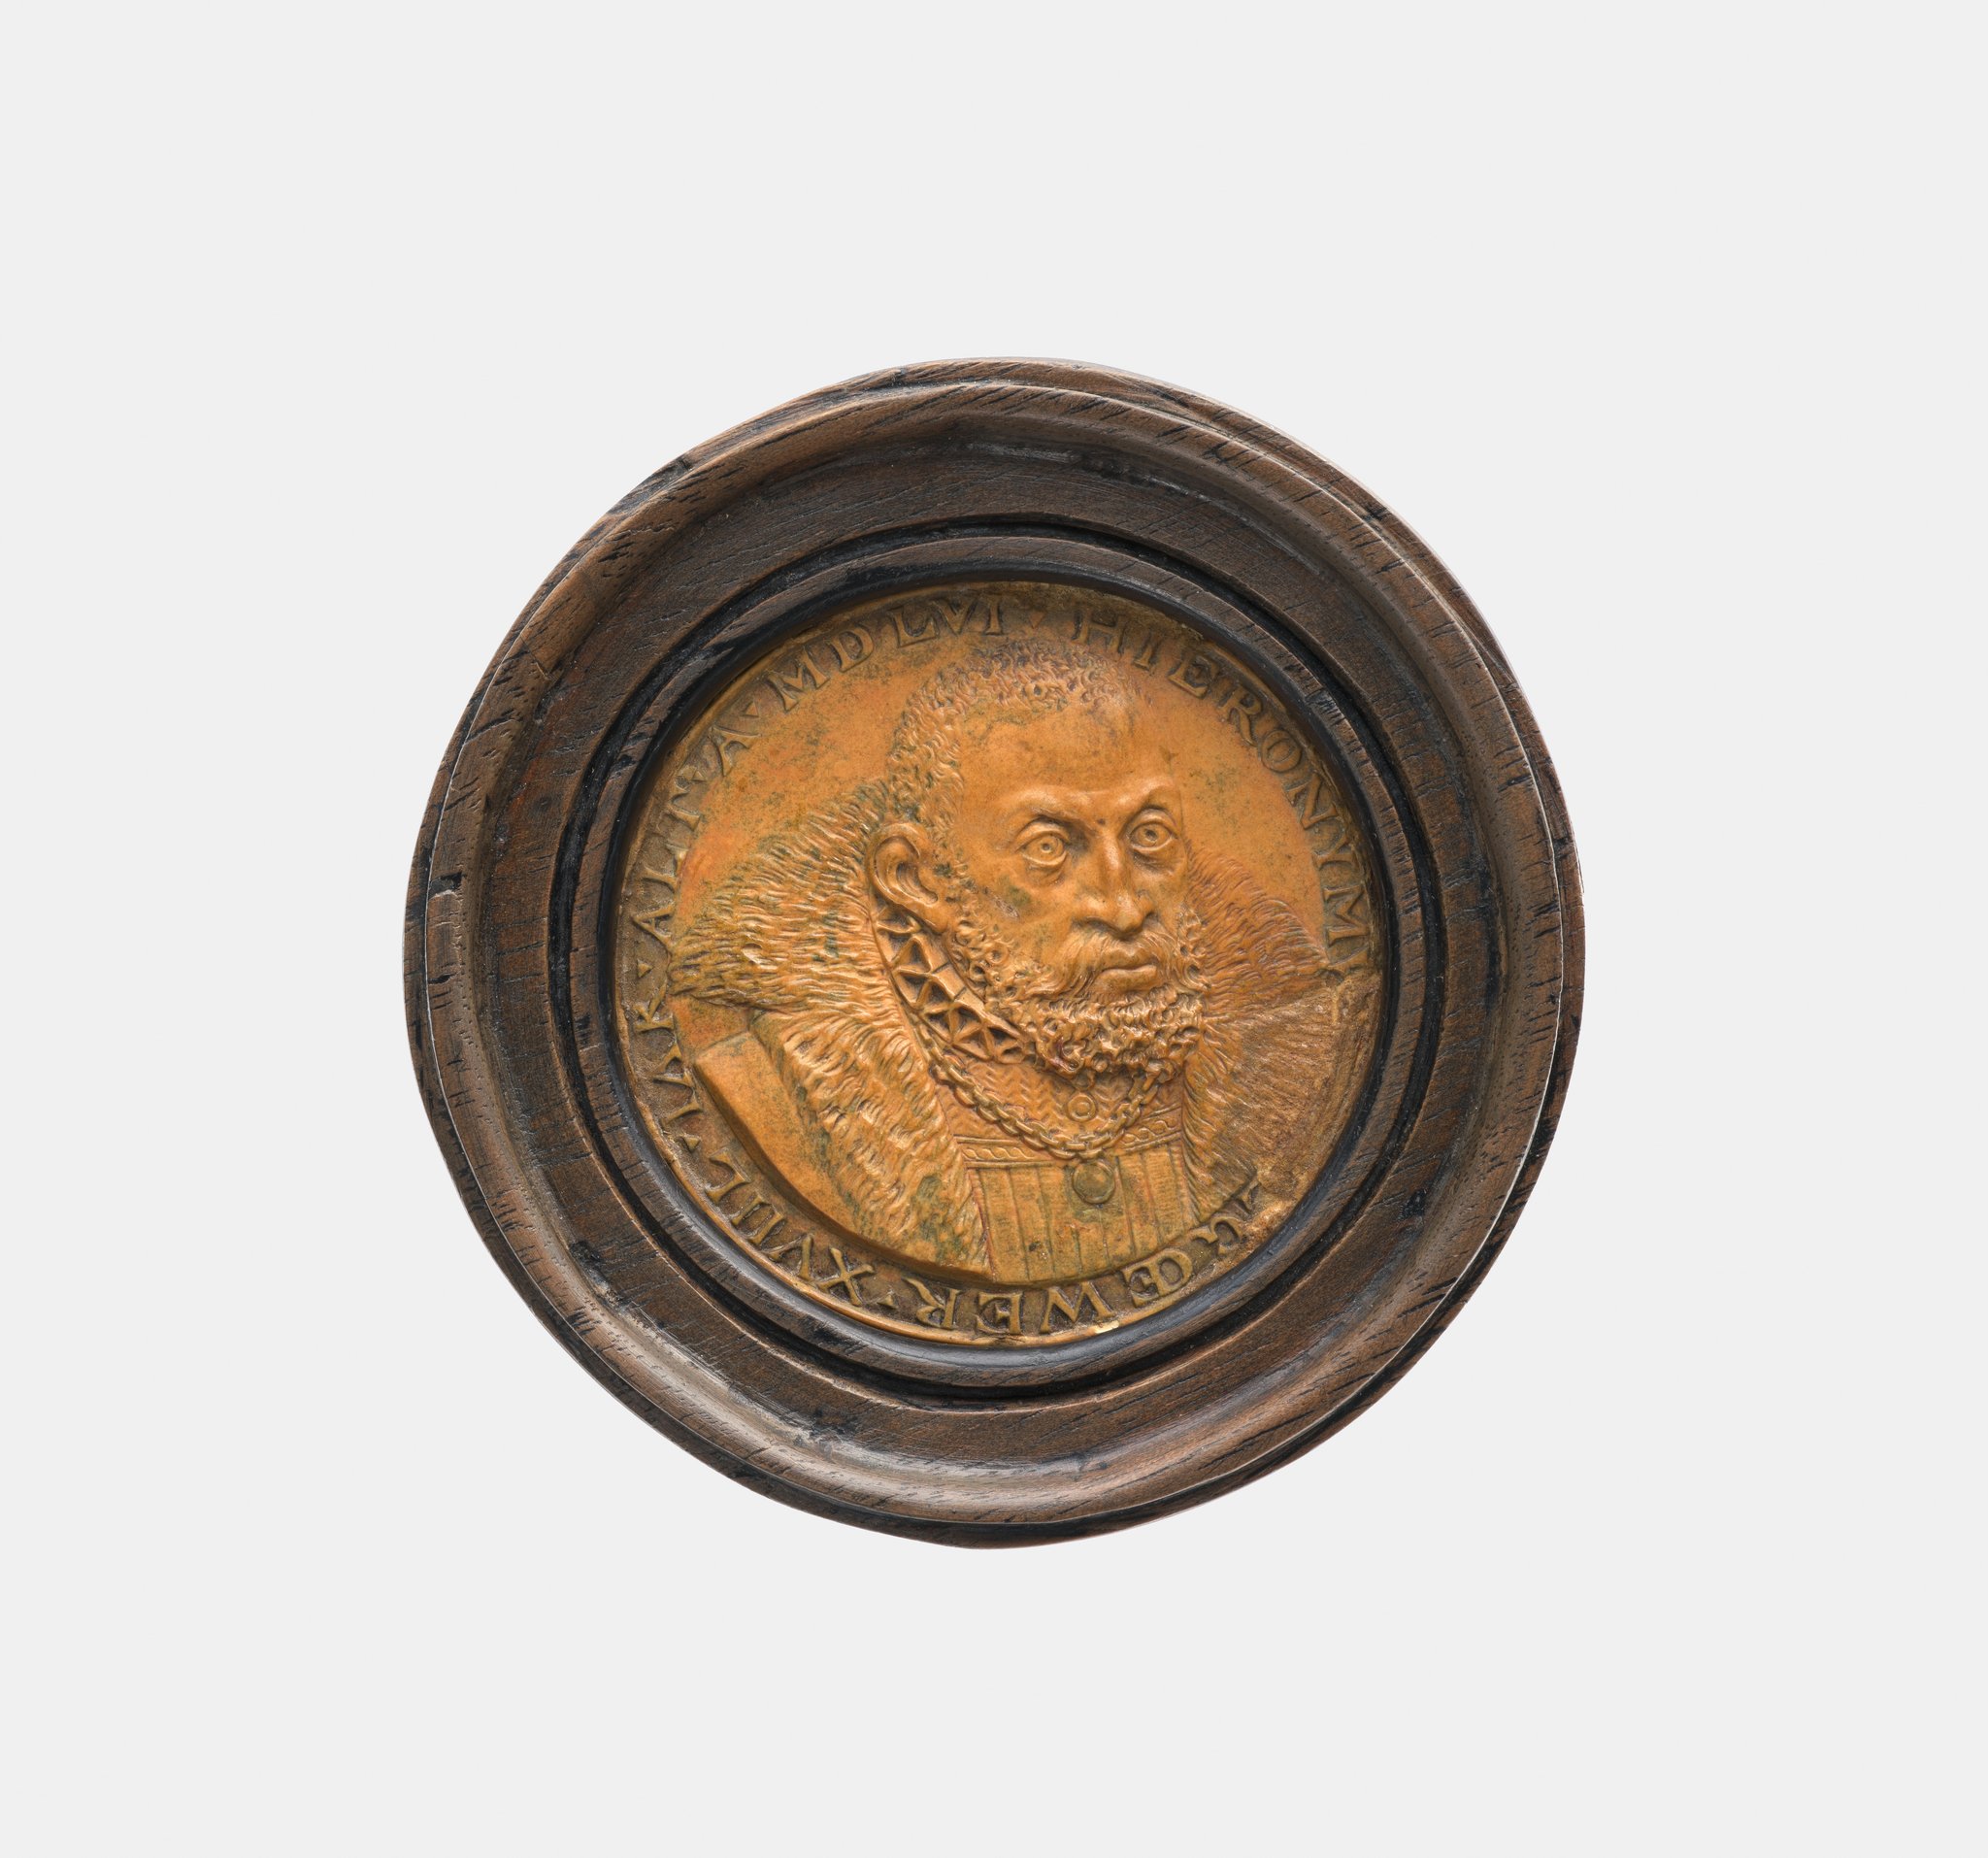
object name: model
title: Hieronymus Allgaeuer (b. 1509)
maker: Anonymous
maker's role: artist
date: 1556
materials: stone, wood